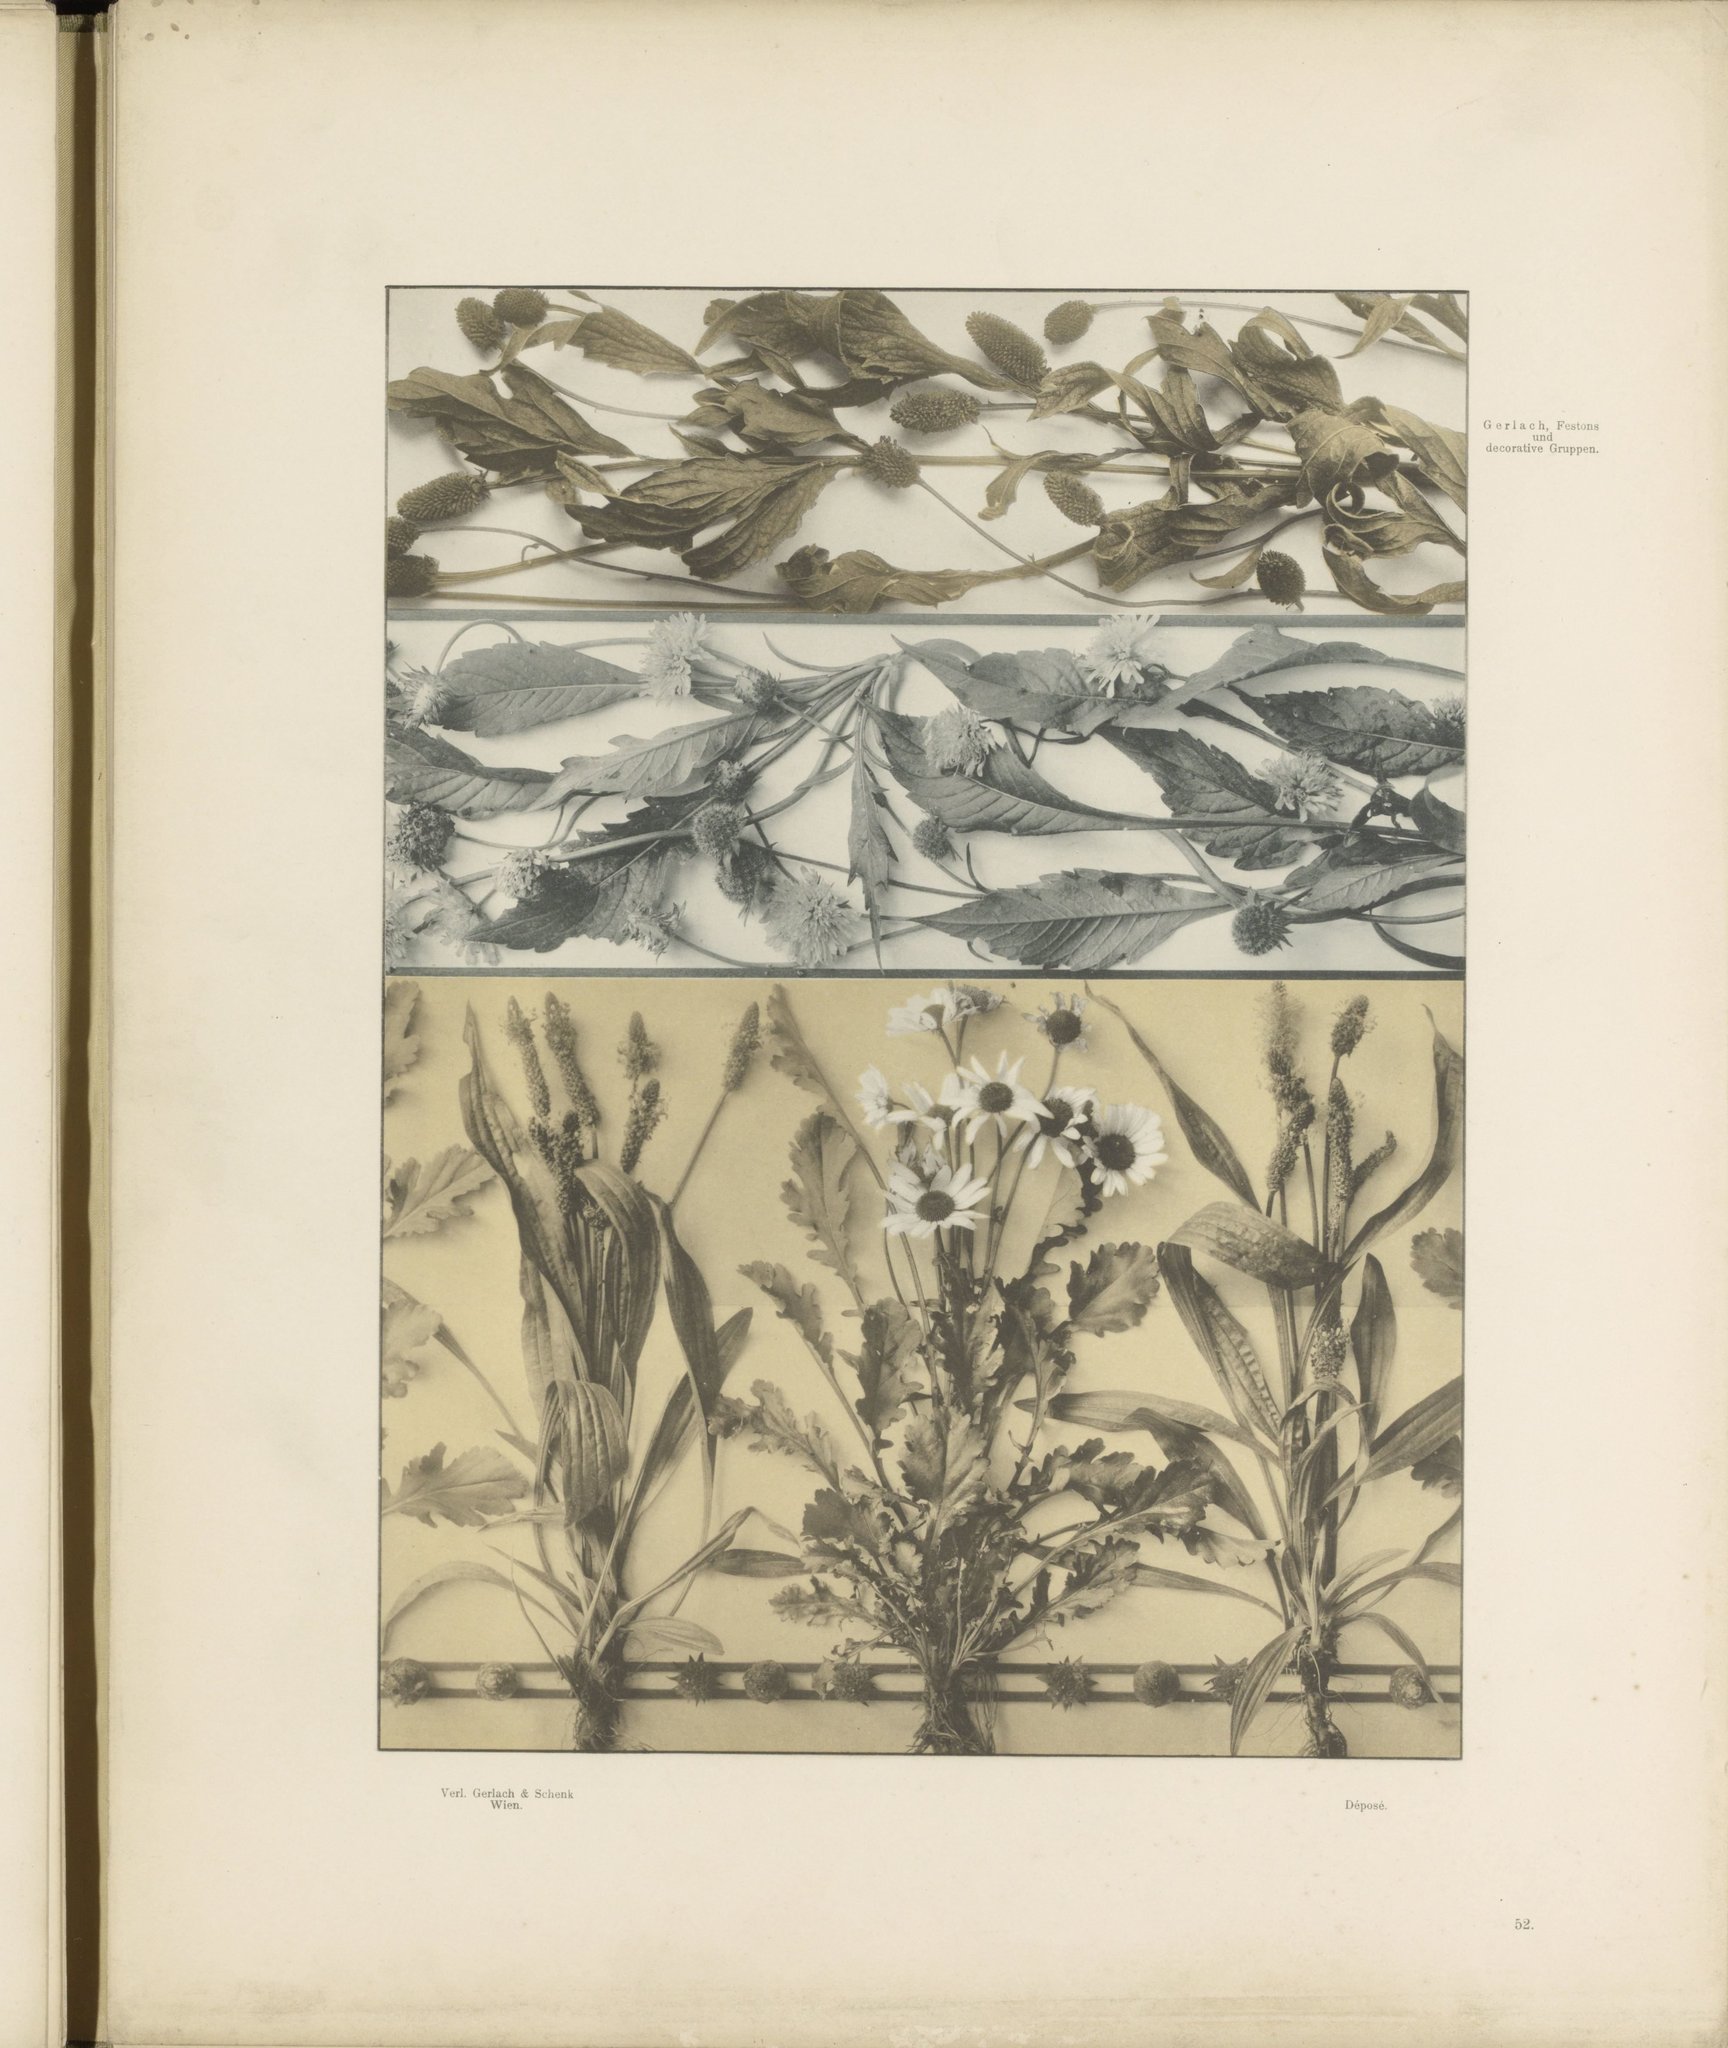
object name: page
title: Vlakvullingen van weegbree en bladeren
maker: Anonymous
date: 1887-1897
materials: paper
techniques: photograph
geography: vienna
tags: foliage, tendrils, branches ~ ornament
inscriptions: number: ‘52.’